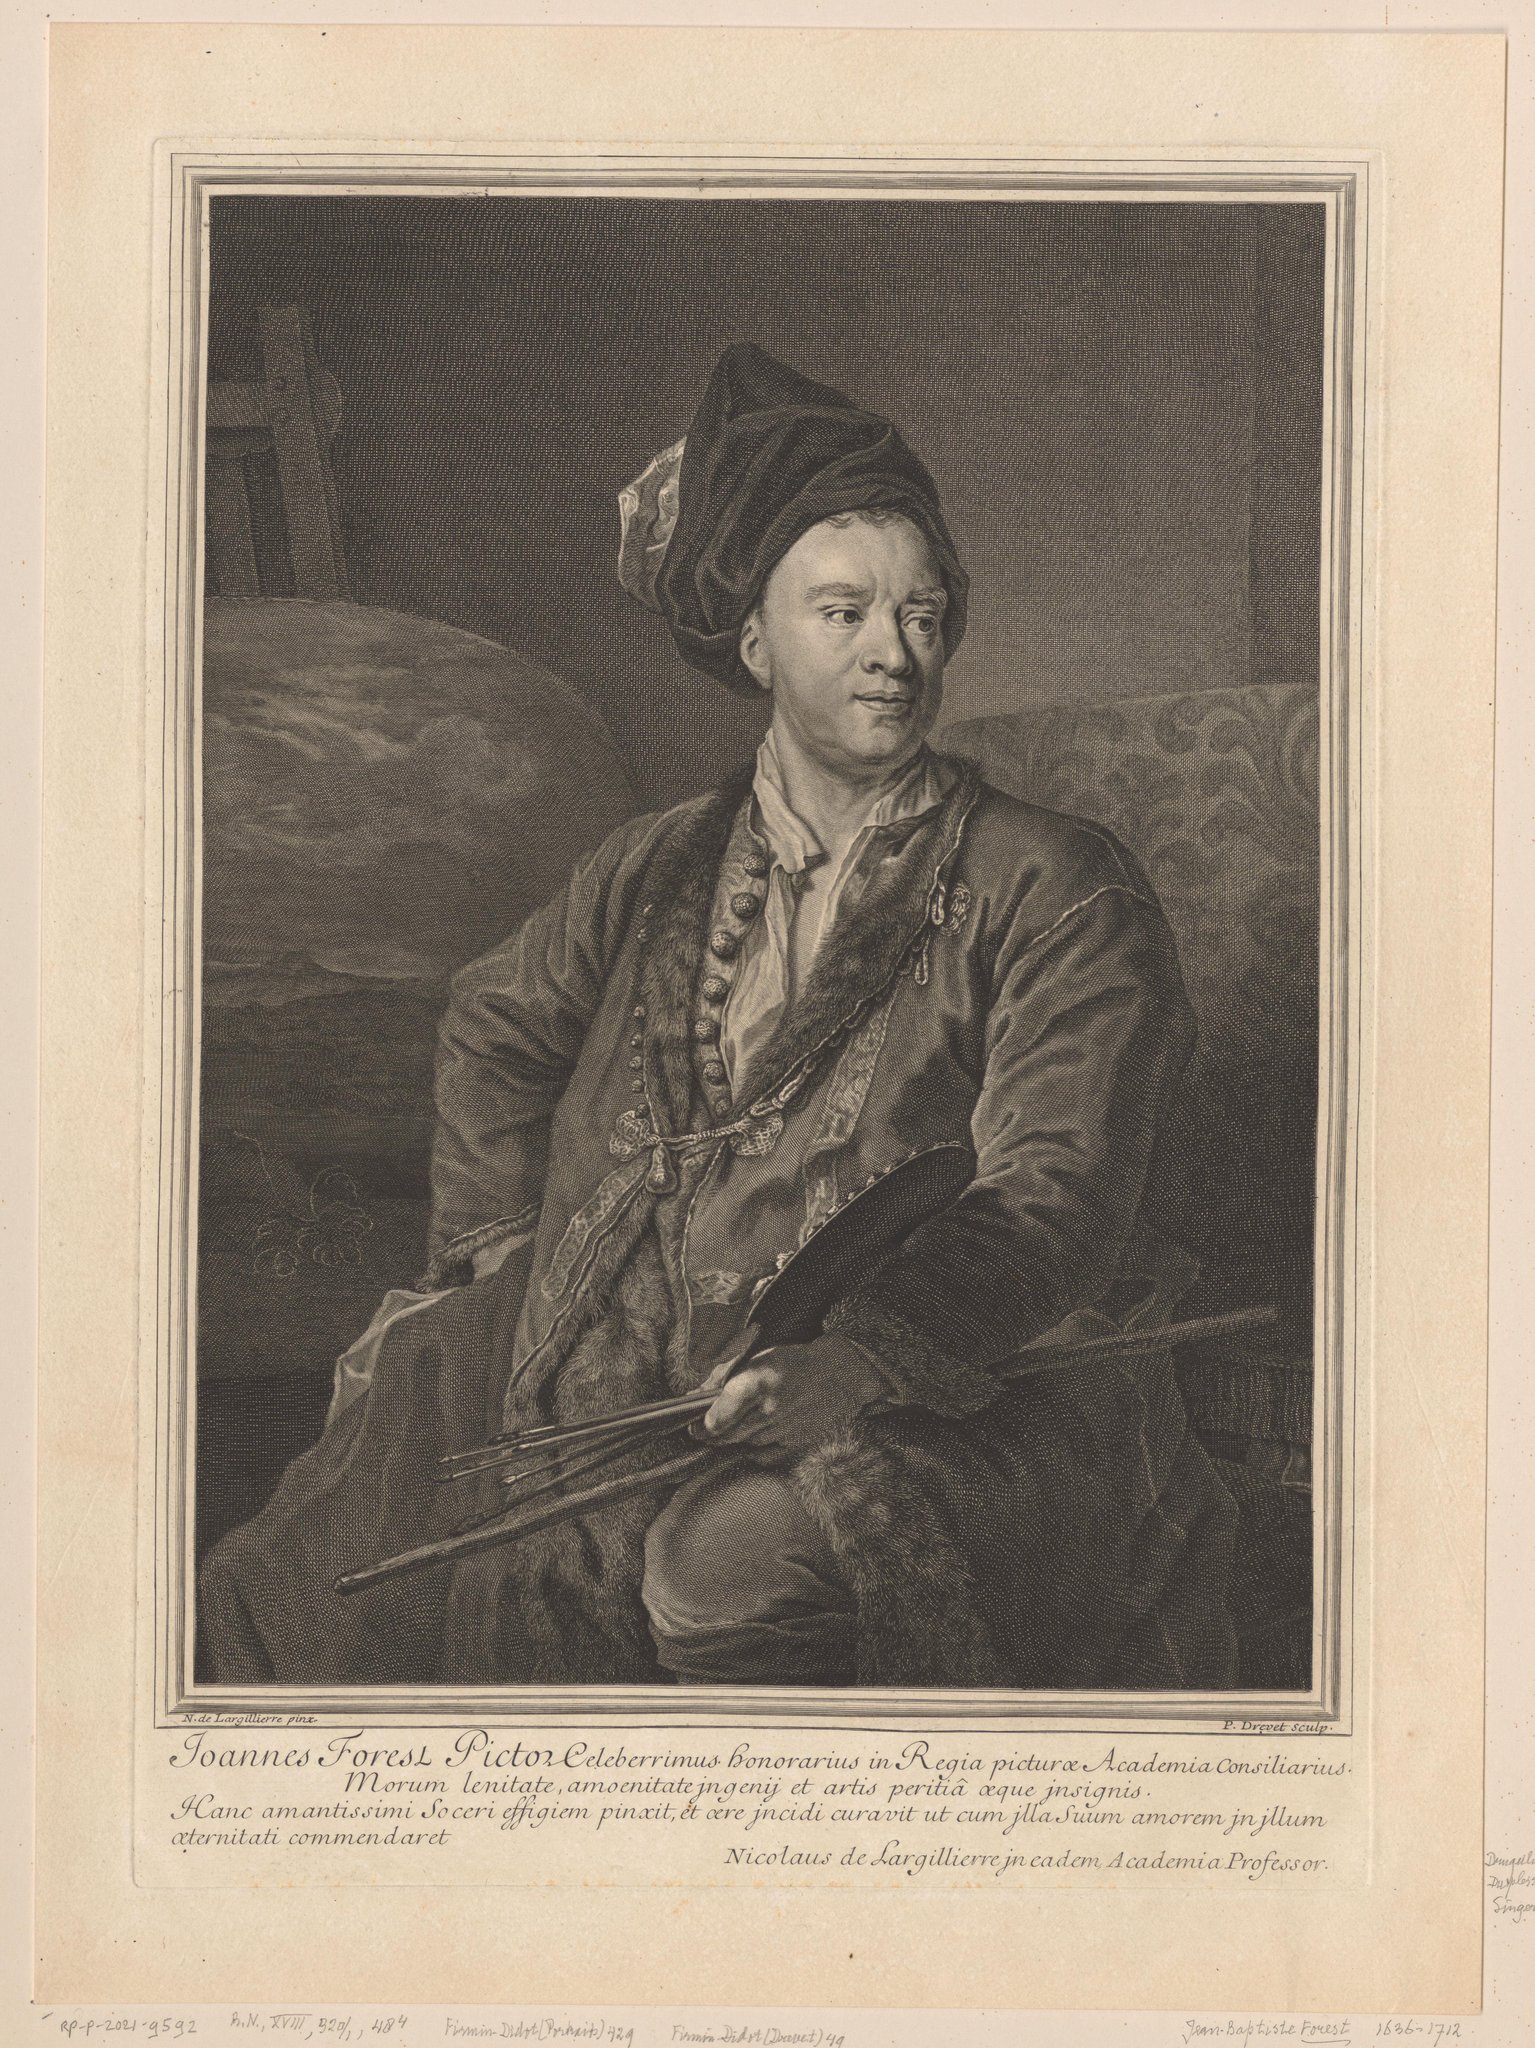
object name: print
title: Portret van Jean-Baptiste Forest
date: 1704-1738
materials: paper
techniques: engraving, etching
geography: france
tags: painter, historical persons, portrait, self-portrait of painter, tools, implements of painter